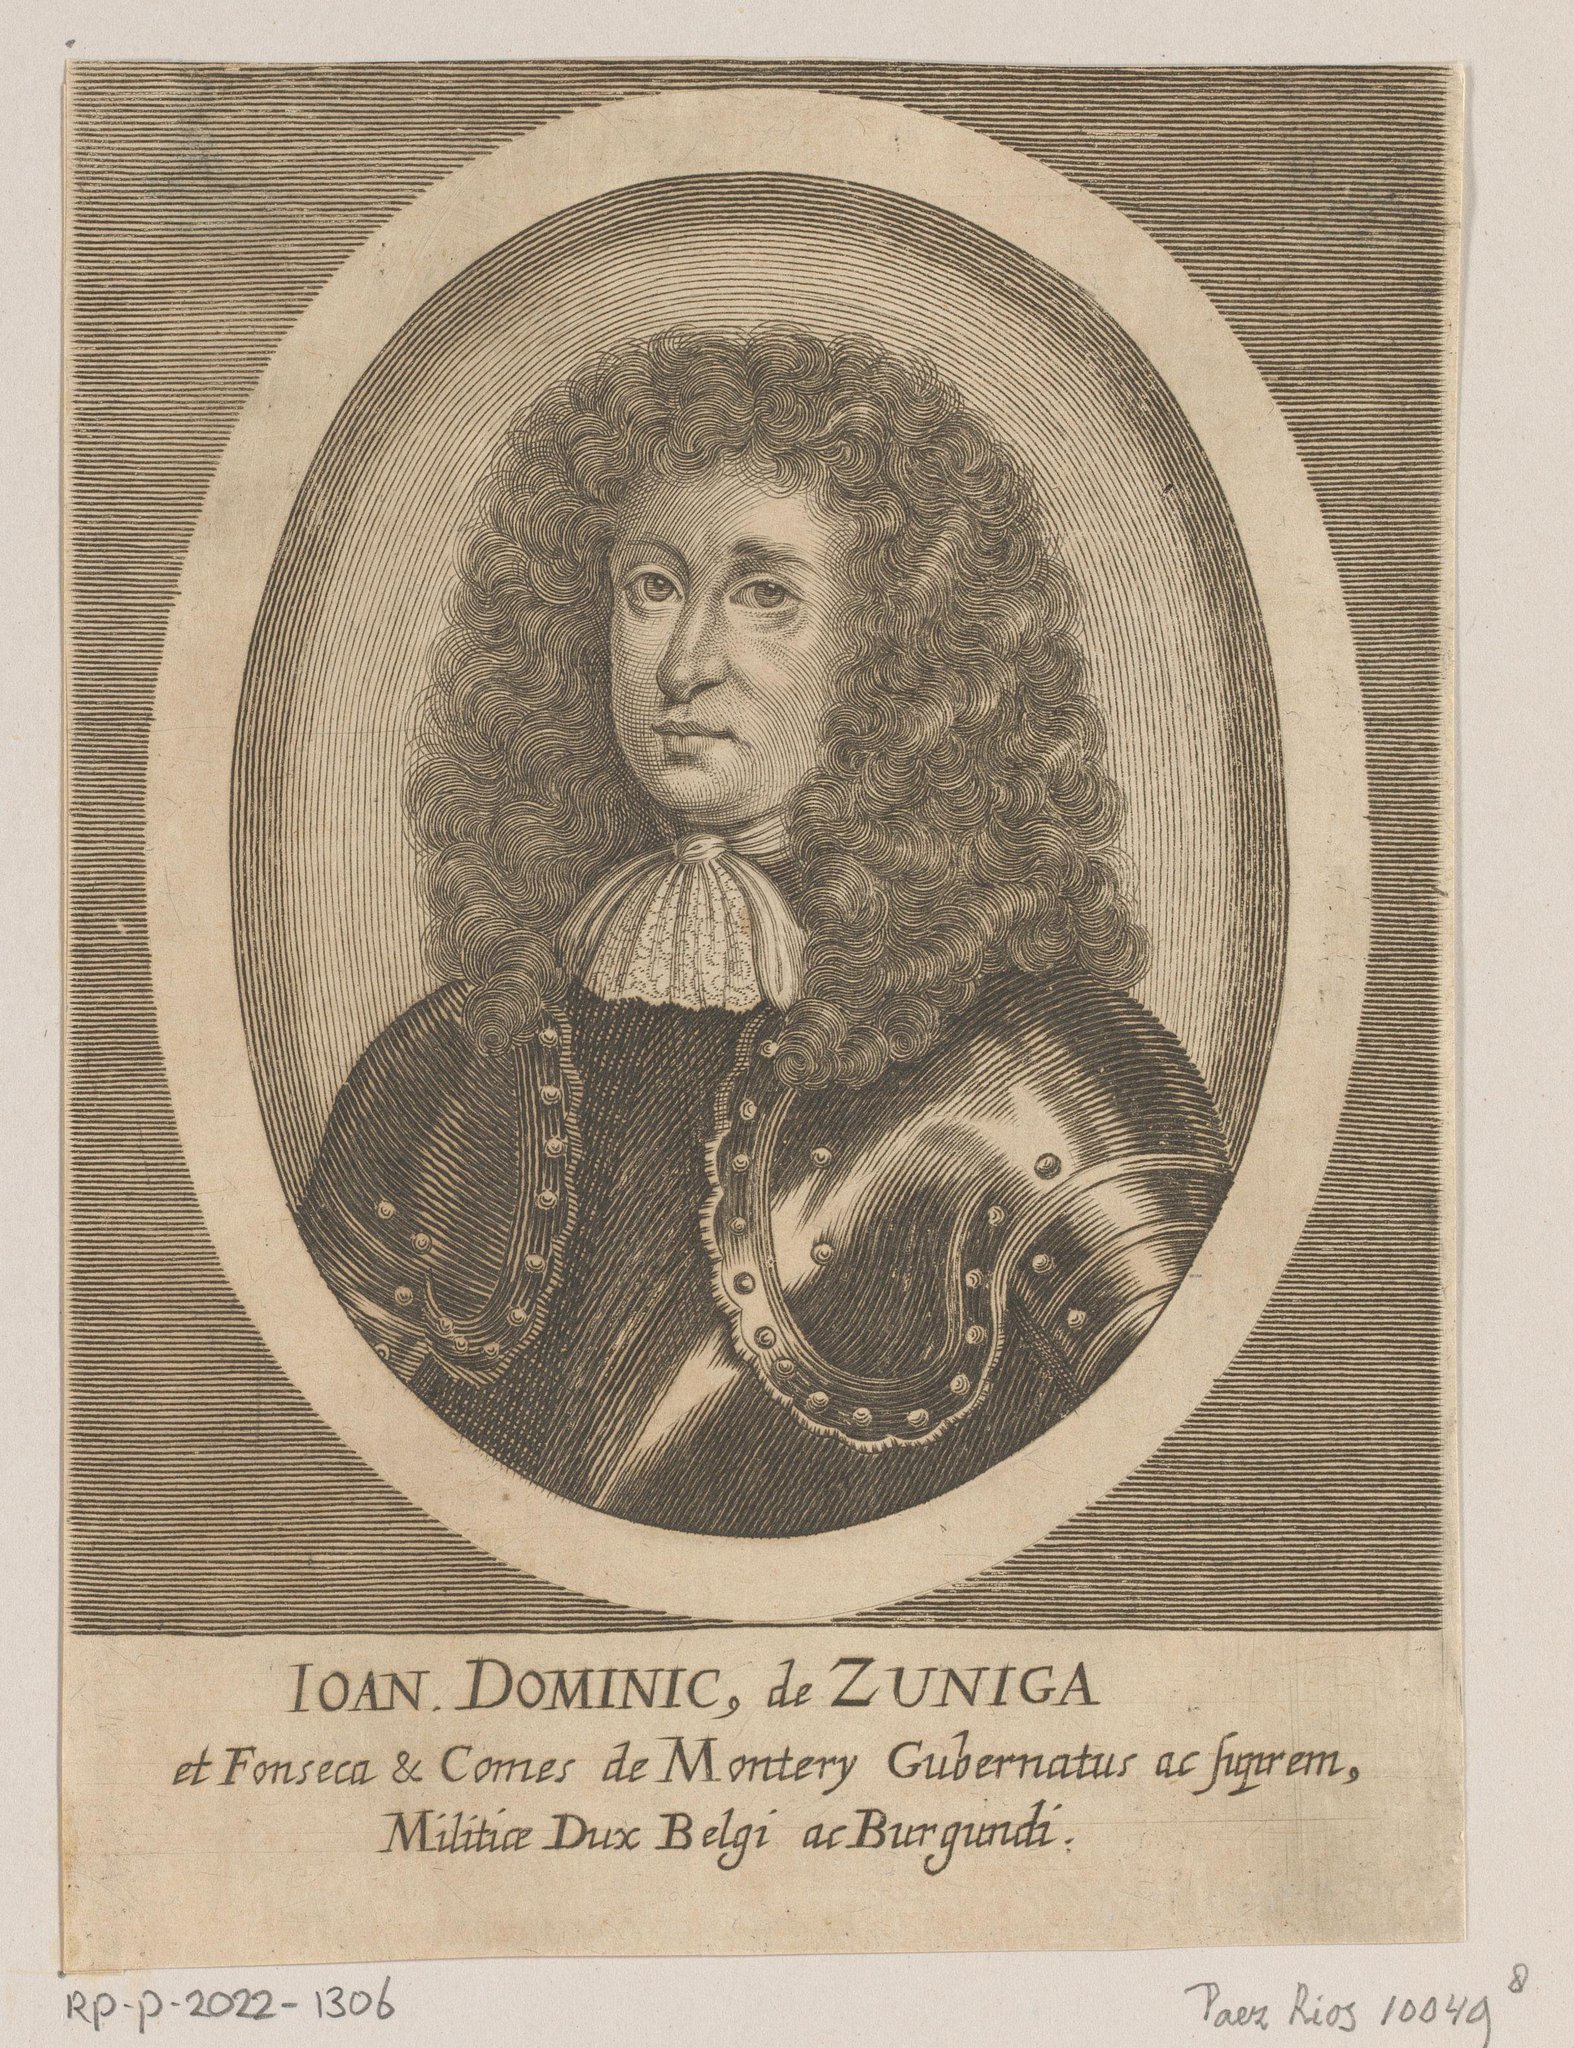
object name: book illustration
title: Portret van Juan Domingo Méndez de Haro y Fernández de Córdoba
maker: Anonymous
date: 1682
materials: paper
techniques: engraving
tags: juan domingo méndez de haro y fernández de córdoba, armour, historical persons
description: Prent waarschijnlijk uit: Theatrum Europaeum. Frankfurt am Main: erven Matthäus Merian, 1682, dl. 11.